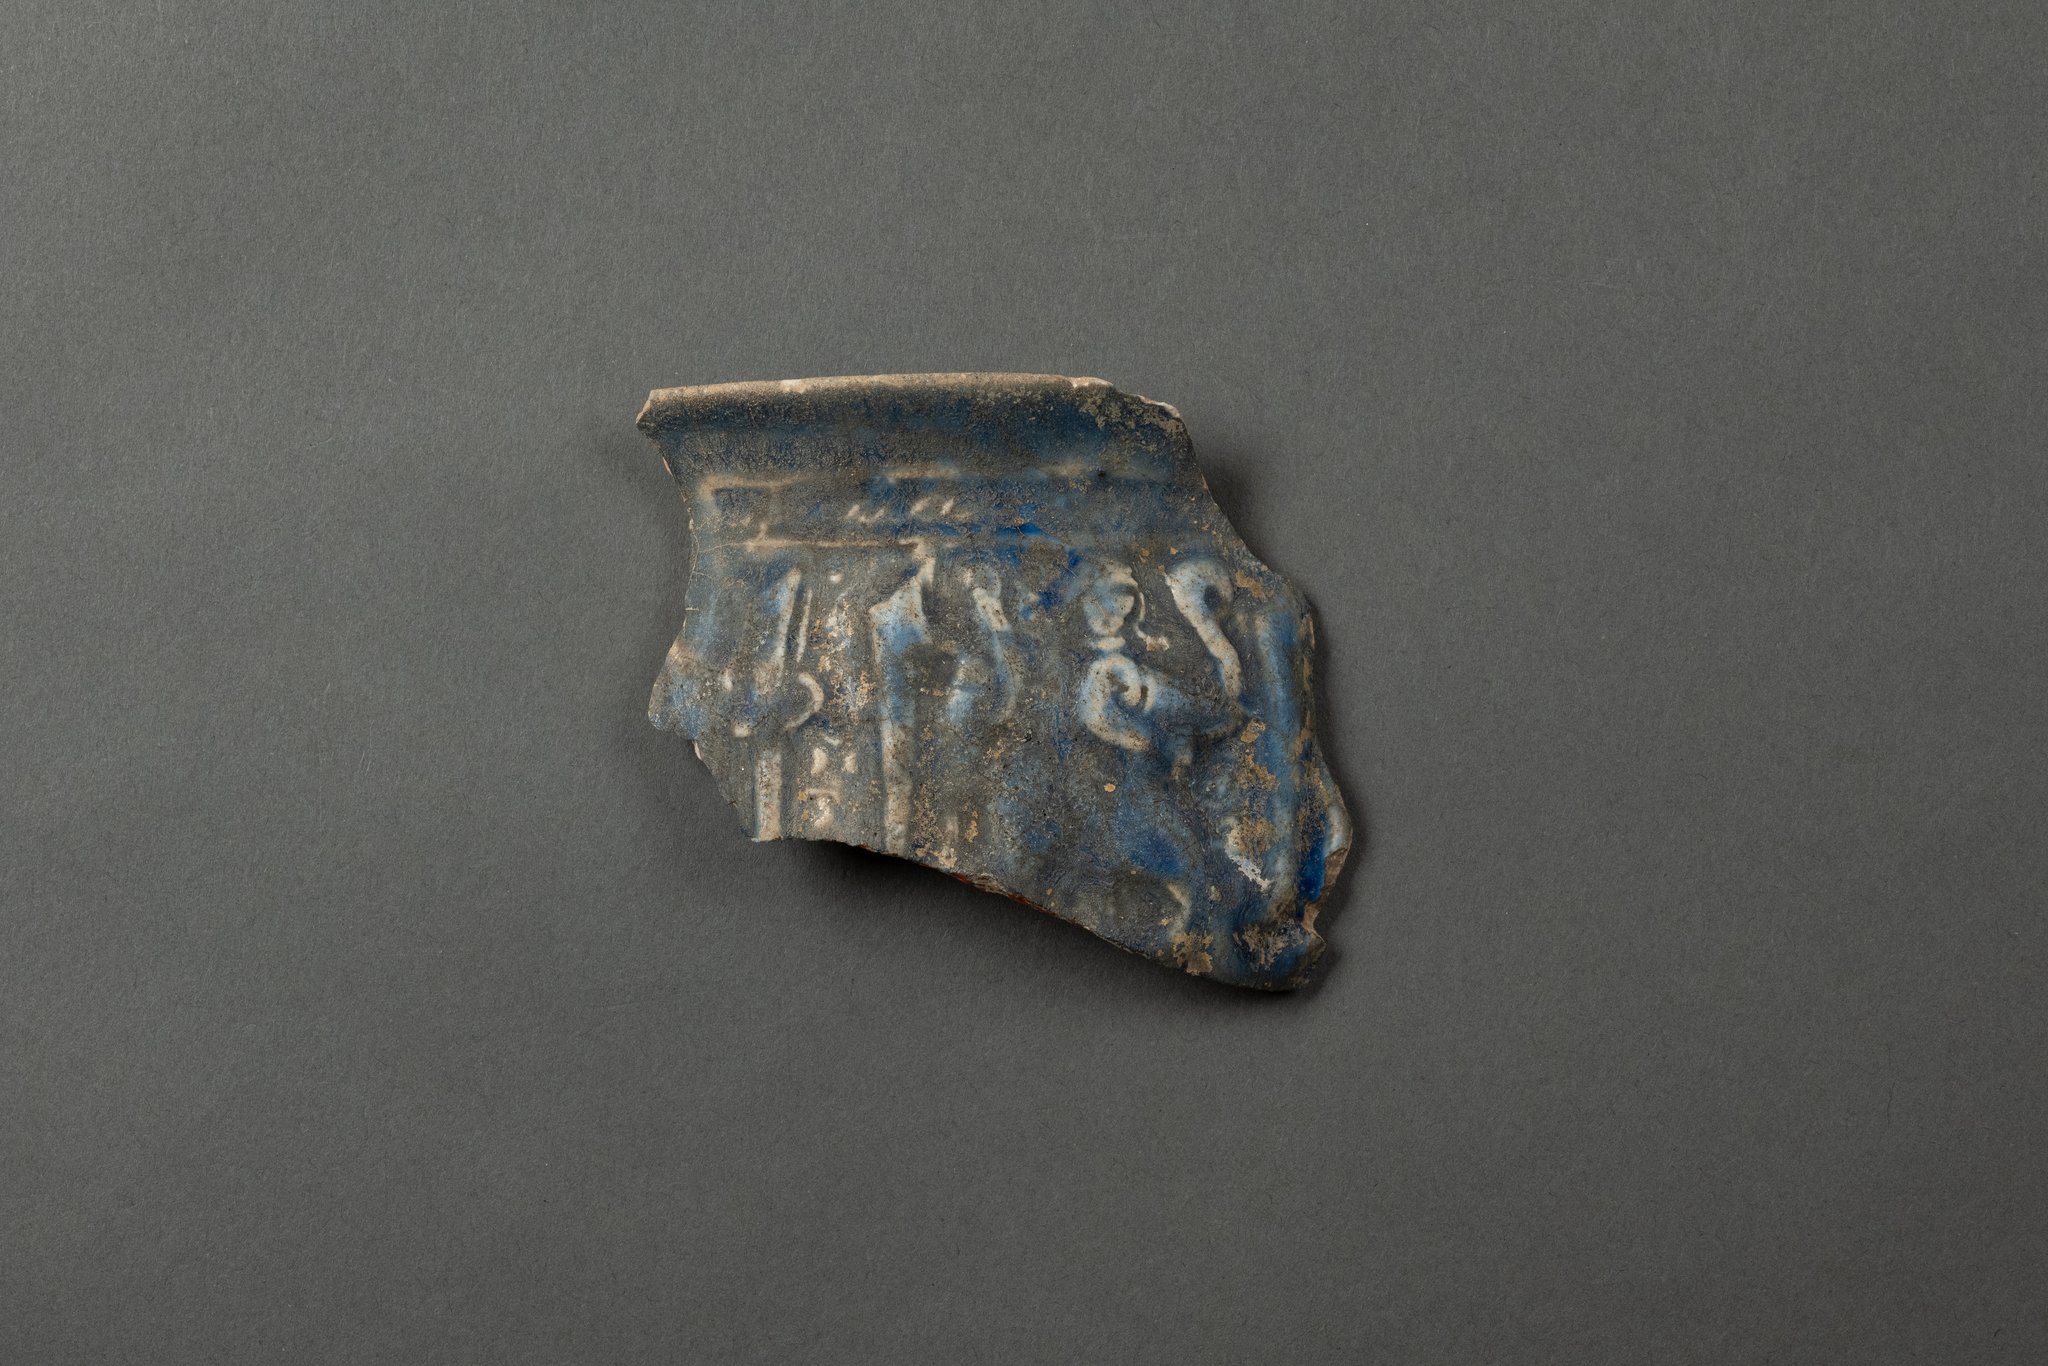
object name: fragment of a bowl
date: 1101-1200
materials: earthenware, glaze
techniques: molding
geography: iran